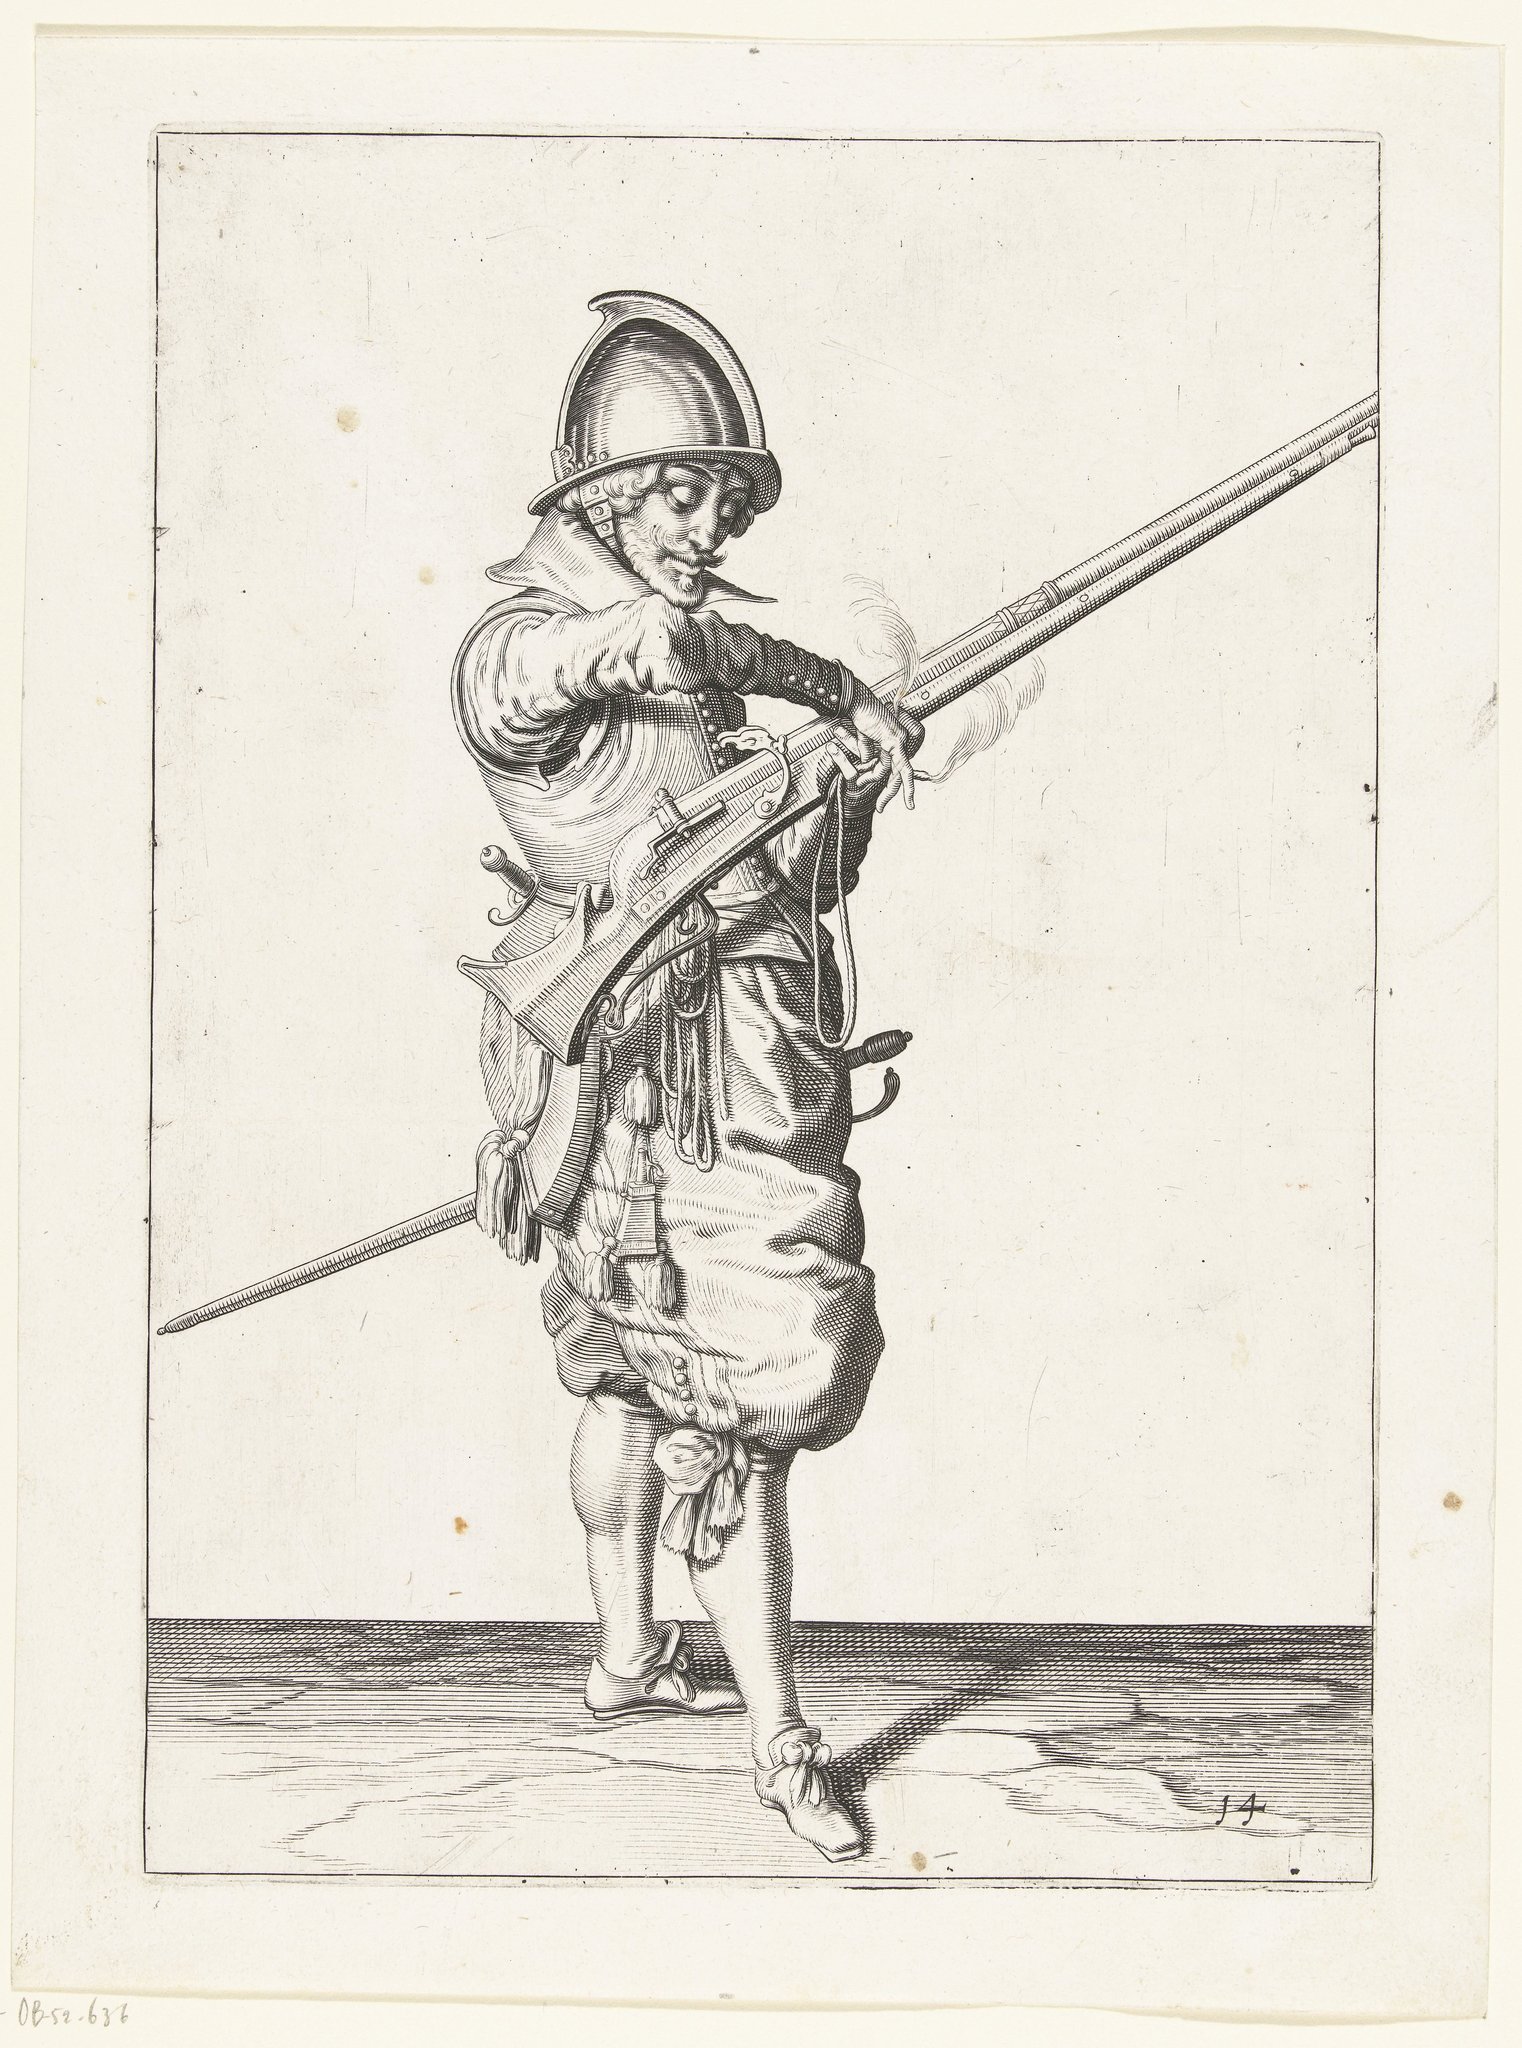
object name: print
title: Soldaat met een roer die zijn lont overbrengt van zijn rechter- naar zijn linkerhand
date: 1597-1607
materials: paper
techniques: engraving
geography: netherlands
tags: manoeuvre ~ military training, firearms: rifle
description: Een soldaat, ten voeten uit, naar rechts, die een roer (een bepaald type vuurwapen) met zijn linkerhand vasthoudt. De brandende lont in zijn rechterhand brengt hij over naar zijn linkerhand. Deze prent is onderdeel van de reeks van 42 genummerde prenten van roerschutters uit de Wapenhandelinghe.